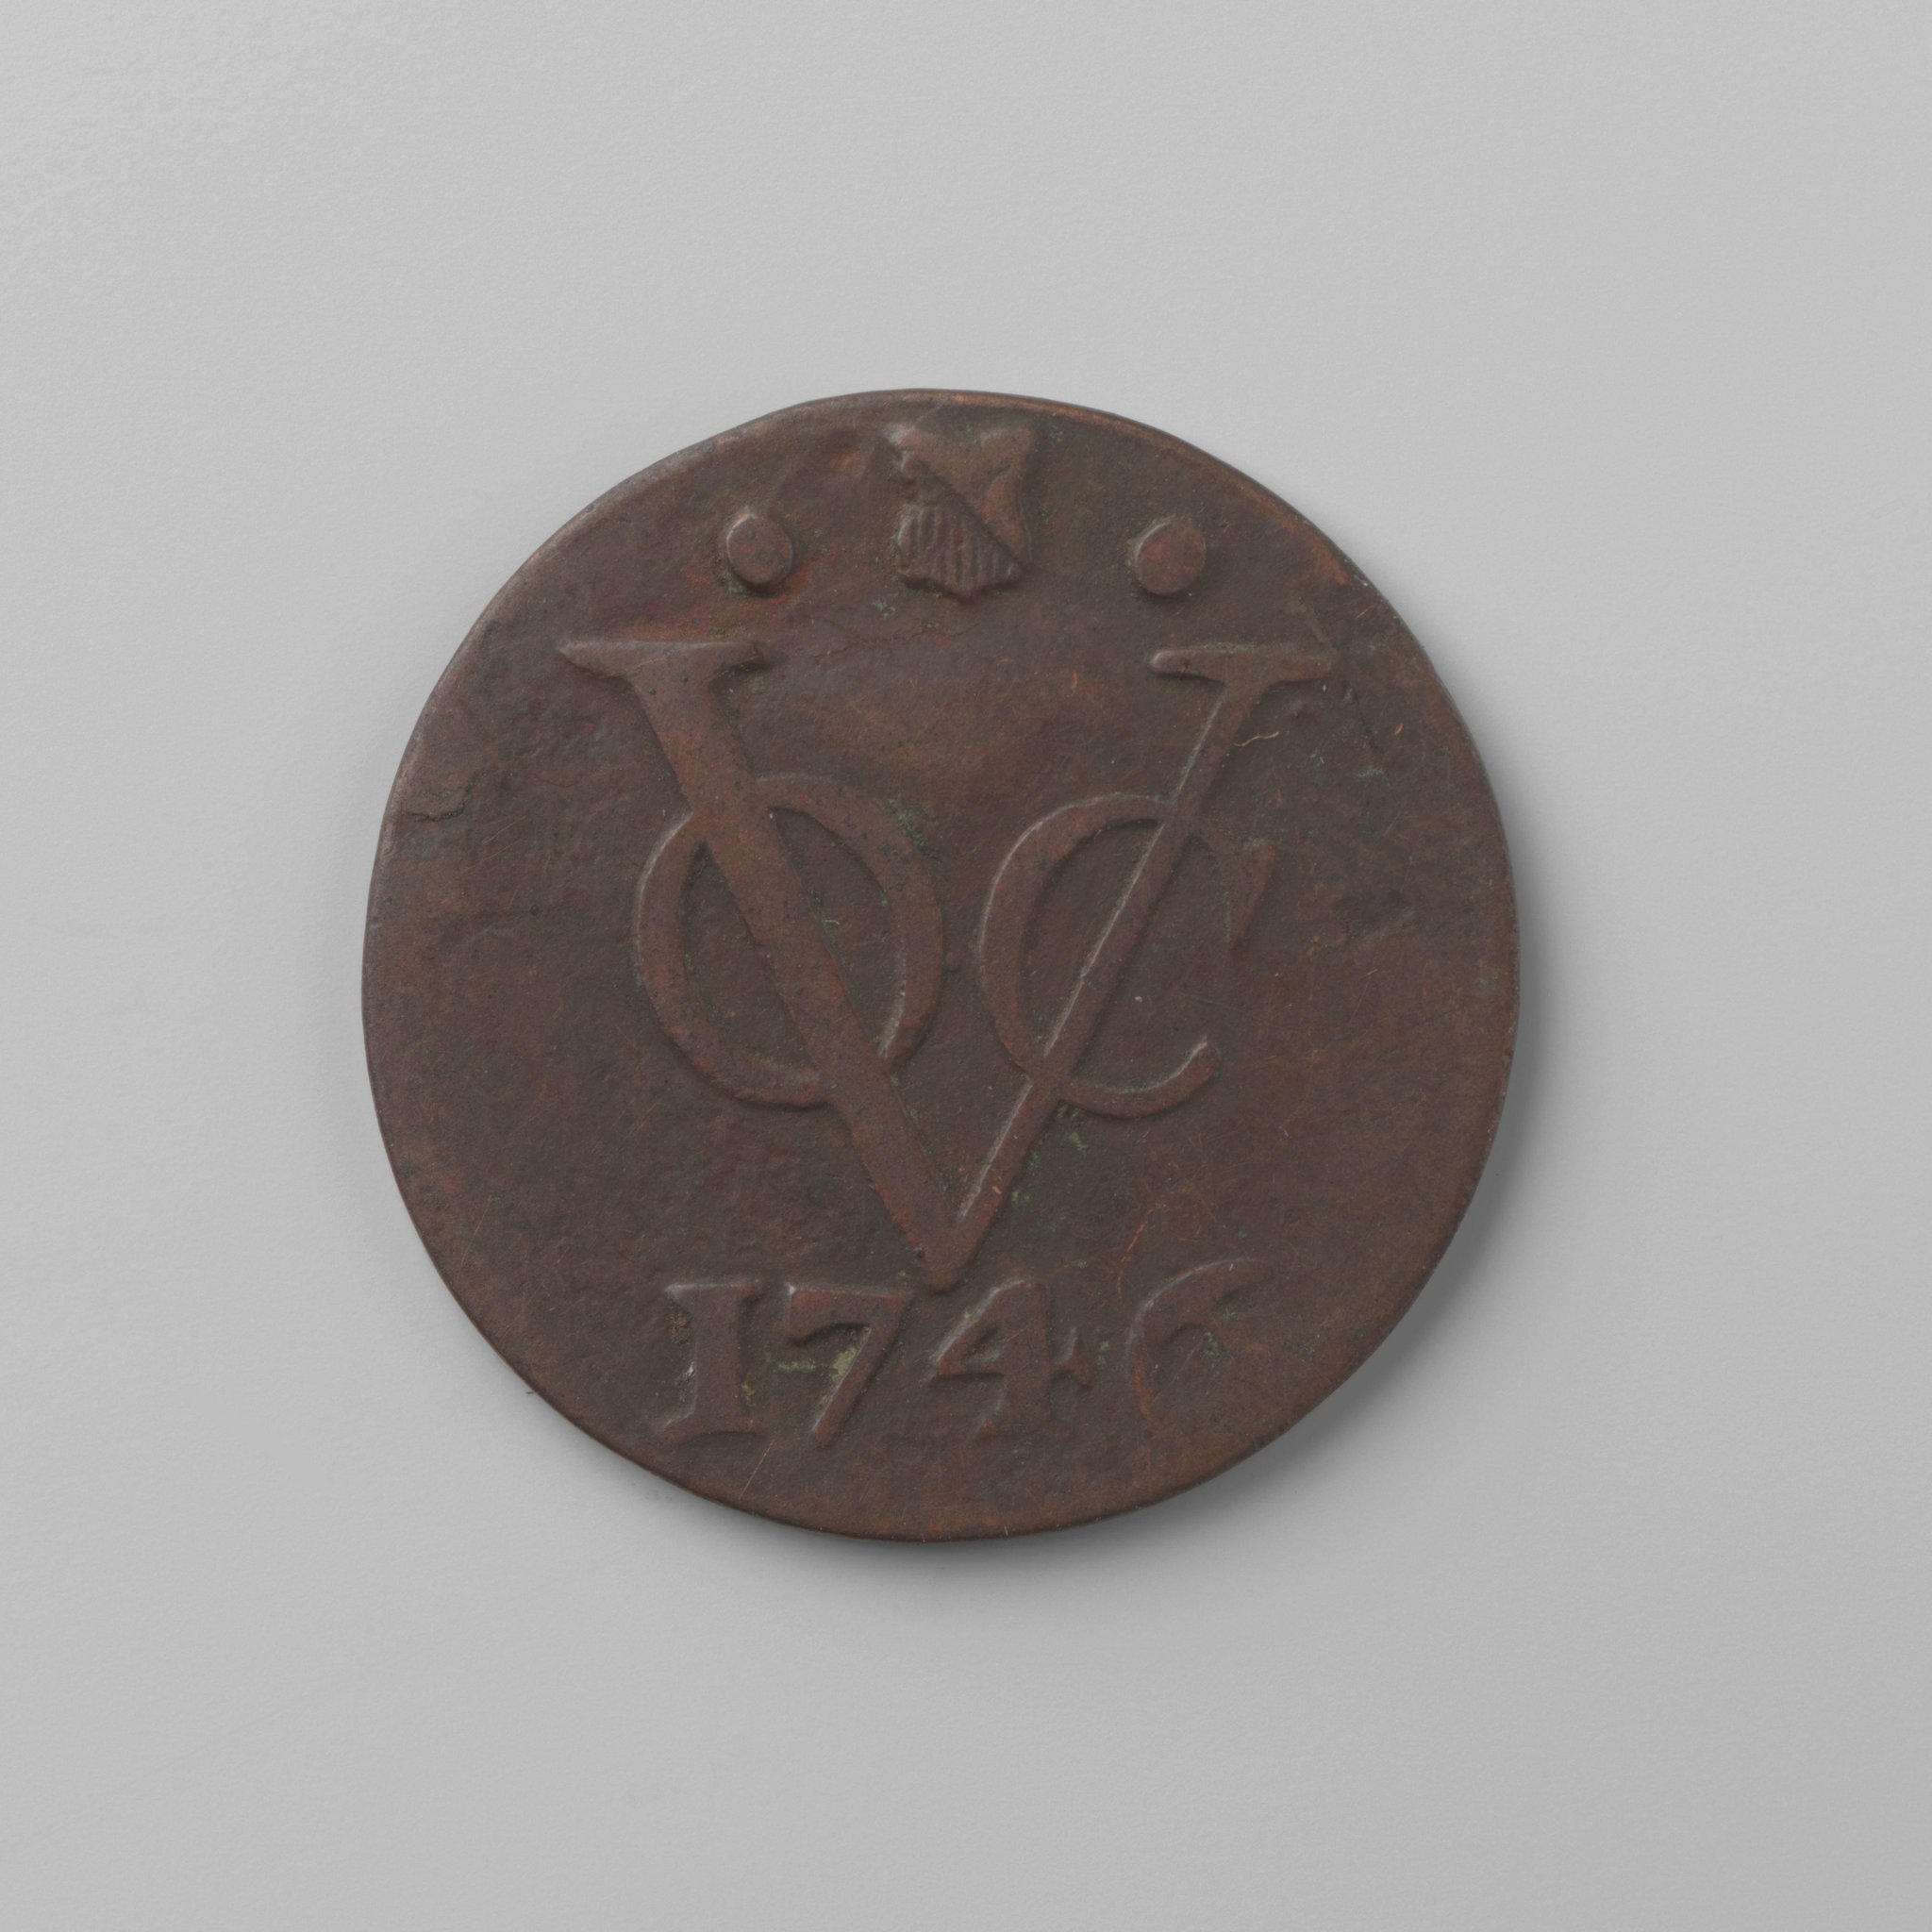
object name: coin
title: VOC, duit stad Utrecht,1746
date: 1746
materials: copper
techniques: striking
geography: utrecht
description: Koperen munt. Voorzijde: op balk, waaronder guirlande, geplaatst, door twee leeuwen gehouden gekroond wapenschild van de stad Utrecht. Keerzijde: monogram van de VOC, waarboven muntteken en waaronder jaartal. Gladde rand.